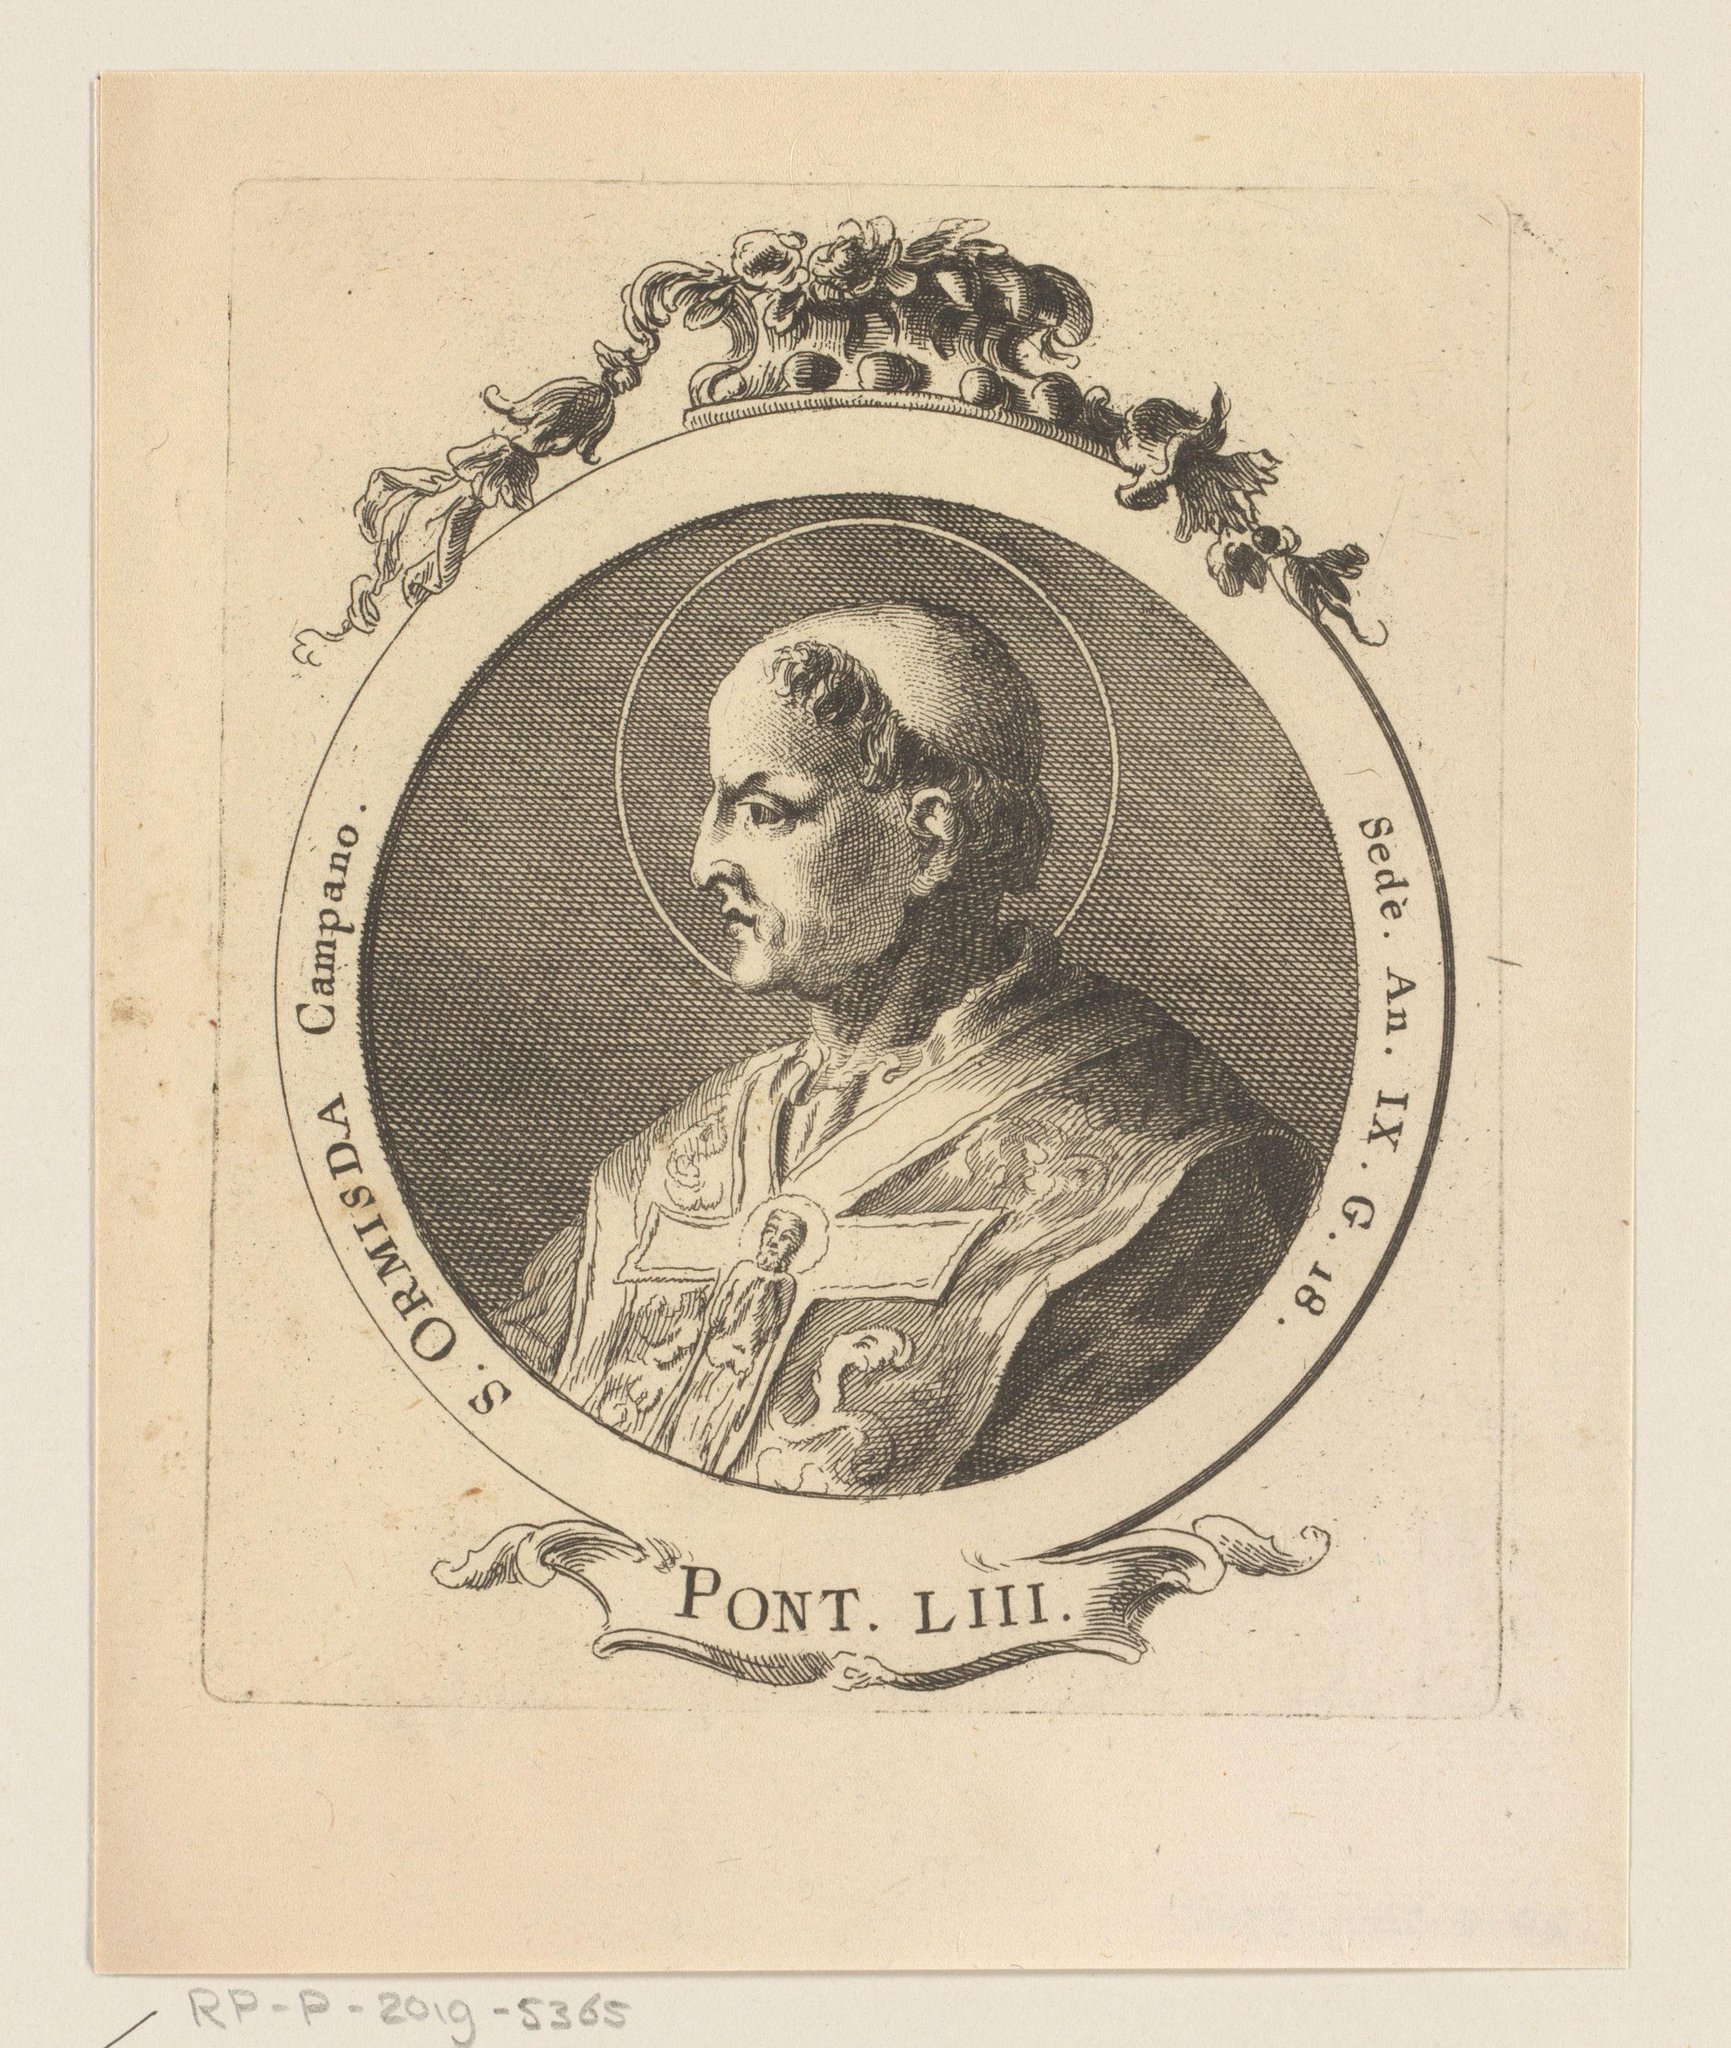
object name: print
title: Portret van paus Hormisdas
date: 1775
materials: paper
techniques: engraving, etching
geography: bassano del grappa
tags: historical persons, pope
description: Prent uit: Effigies Romanorum pontificum a S. Petro ad Pium VI. feliciter regnantem (...). 2 dln. Venetië en Bassano del Grappa: Giuseppe Remondini, 1775.